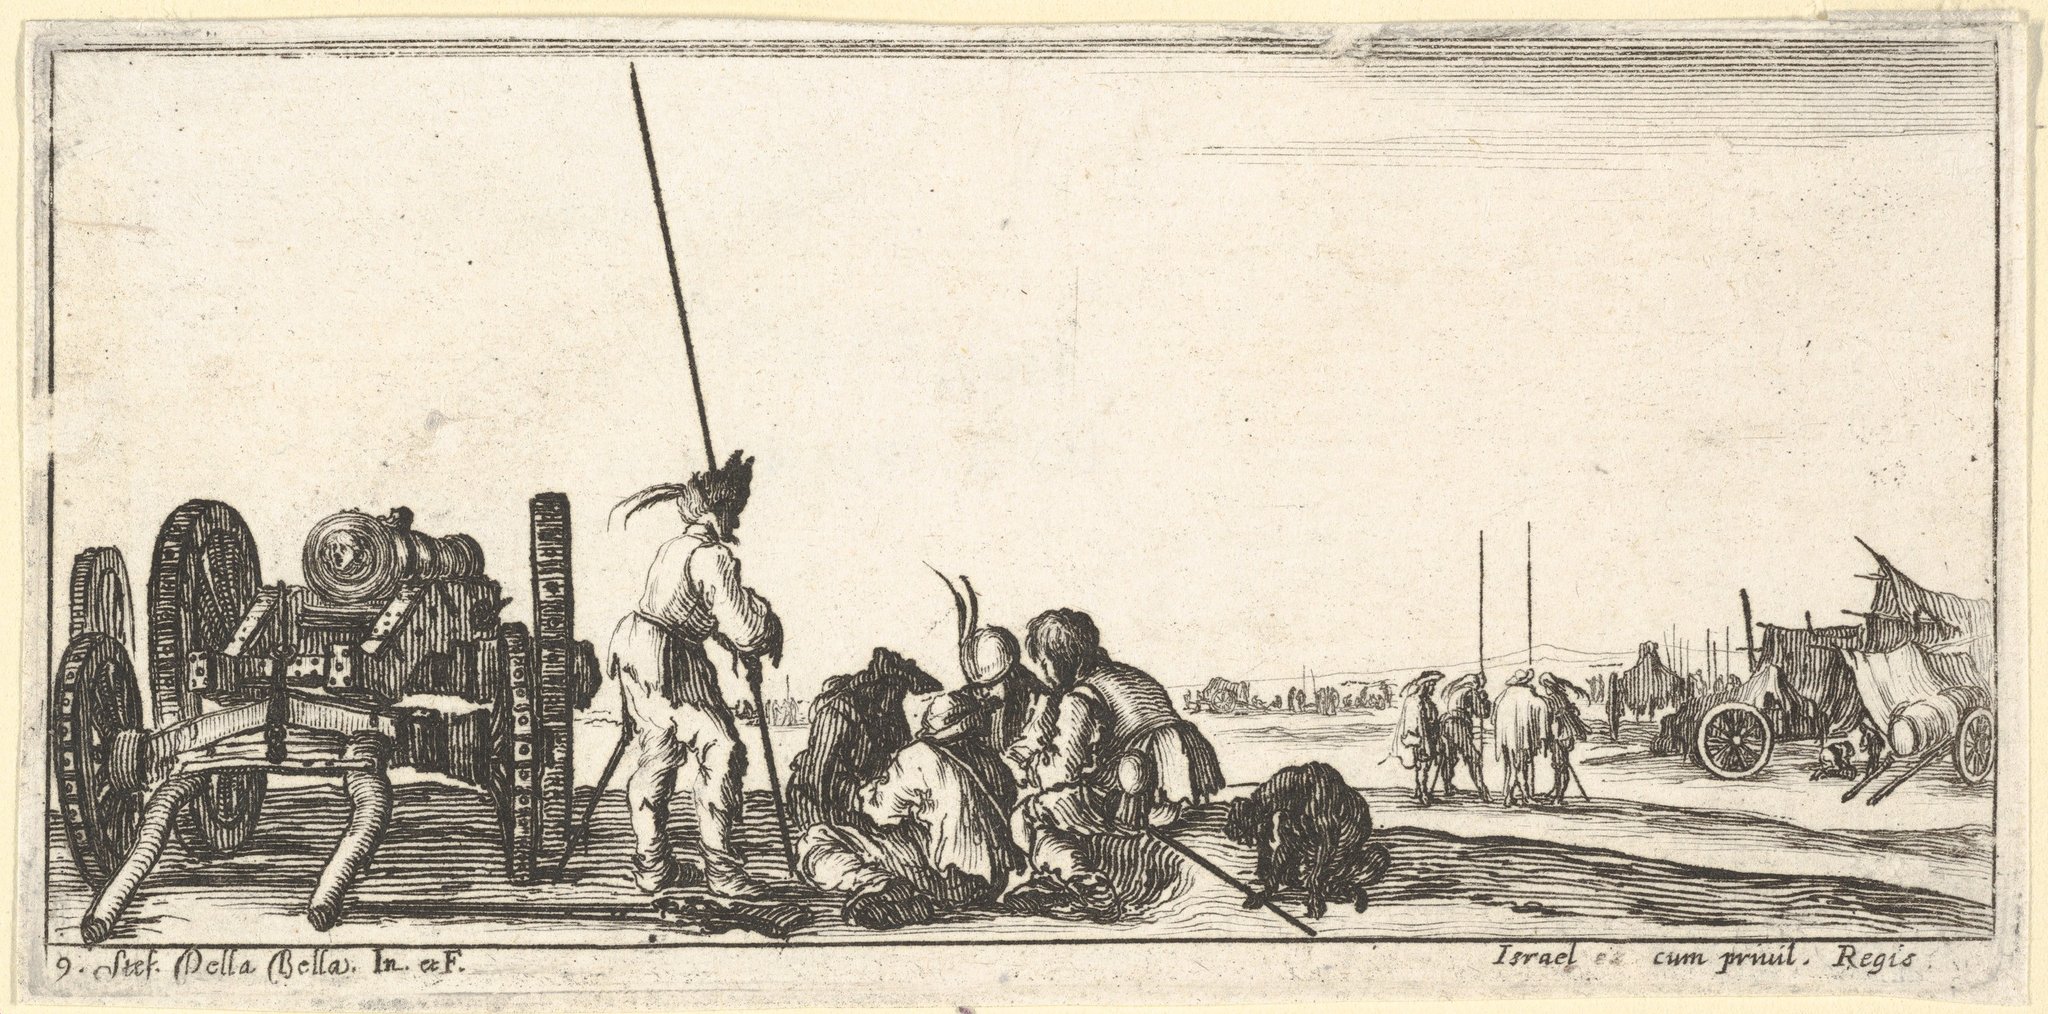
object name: print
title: Plate 9: a chariot carrying a cannon to left, soldiers in center playing cards, from "Troops, cannons, and attacks on towns" (Dessins de quelques conduites de troupes, canons, et ataques de villes)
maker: stefano della bella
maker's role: artist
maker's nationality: italian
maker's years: 1610-1664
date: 1640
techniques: etching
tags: soldiers,cannons,playing cards